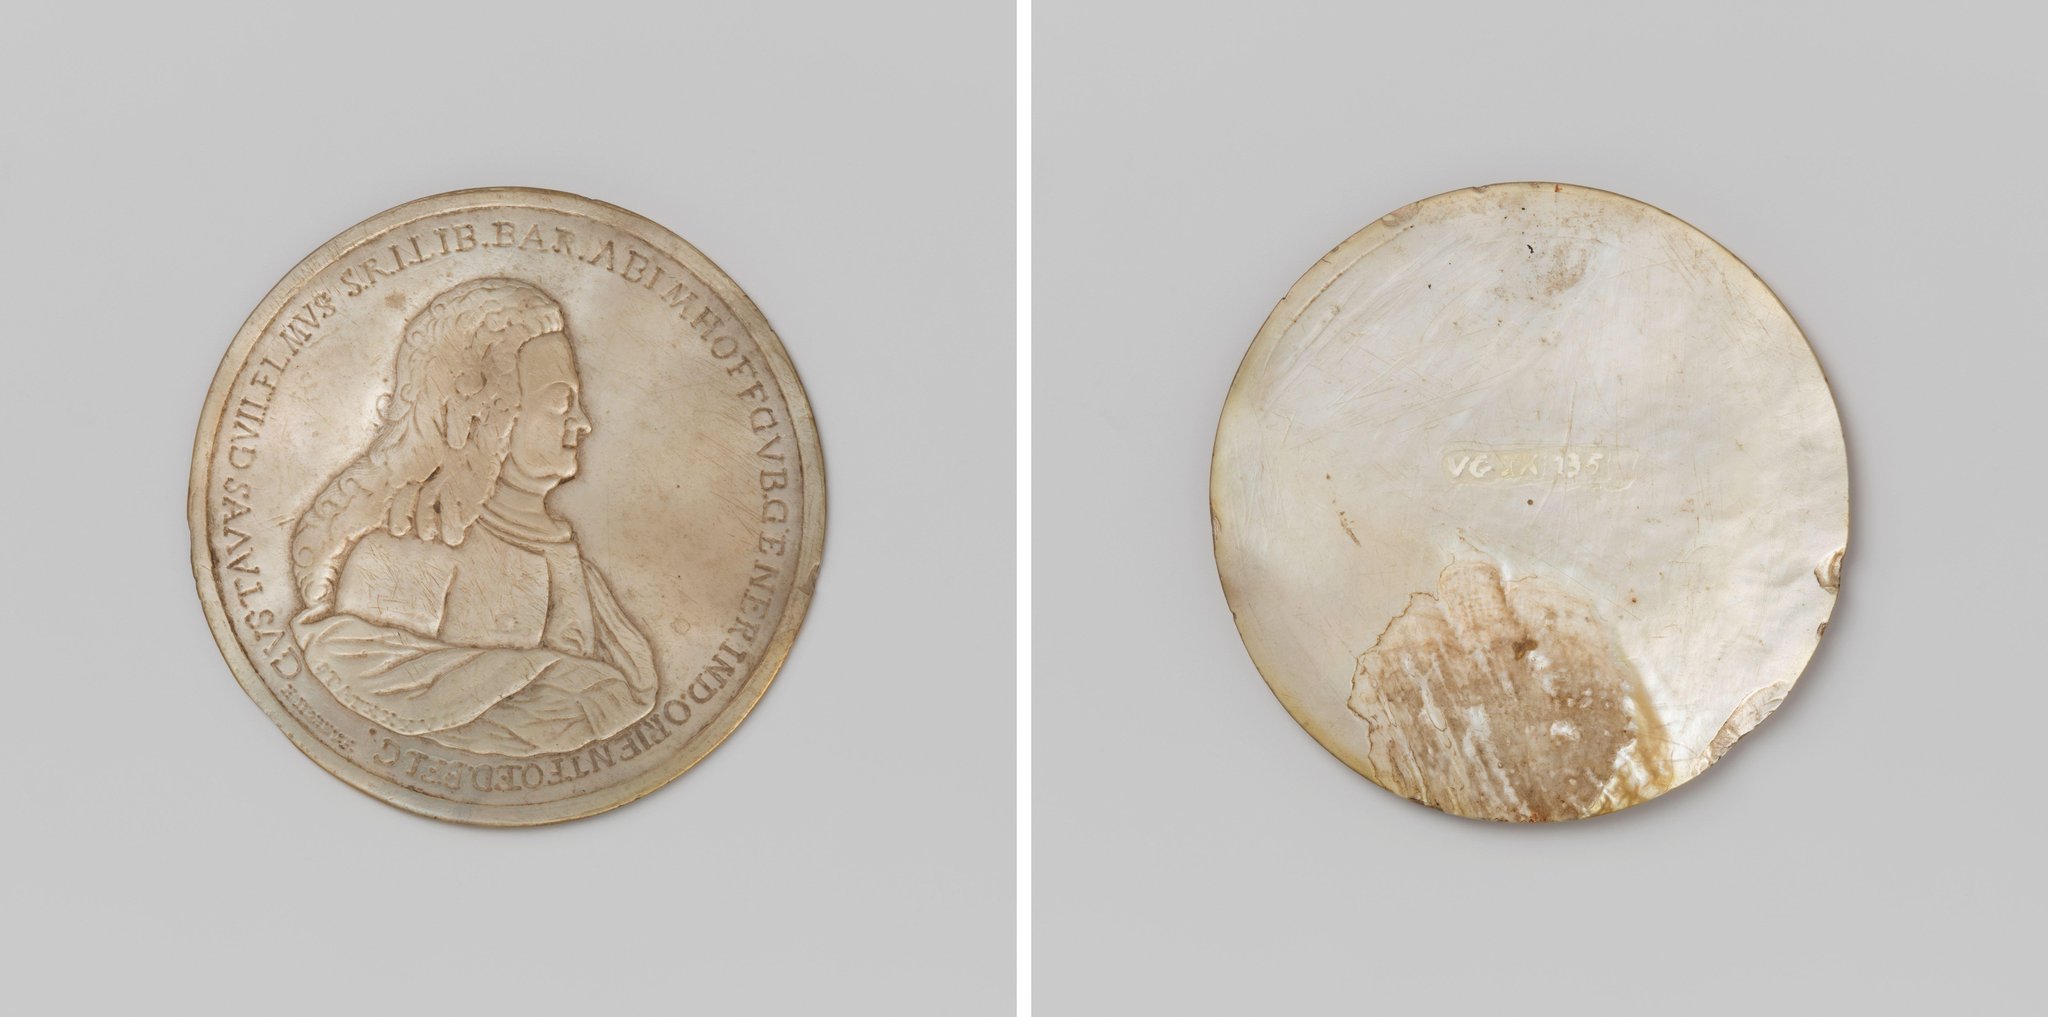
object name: plaque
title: Gustaaf Willem, baron van Imhoff, gouverneur-generaal van Nederlands-Indië vertrekt uit Amsterdam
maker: martinus holtzhey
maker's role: medailleur, muntmaker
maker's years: 1697-1764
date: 1742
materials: mother of pearl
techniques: cutting, engraving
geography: amsterdam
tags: batavia, dutch east indies, the, amsterdam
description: Eenzijdige plaquette. Voorzijde: borststuk man binnen omschrift. Keerzijde: blanco.